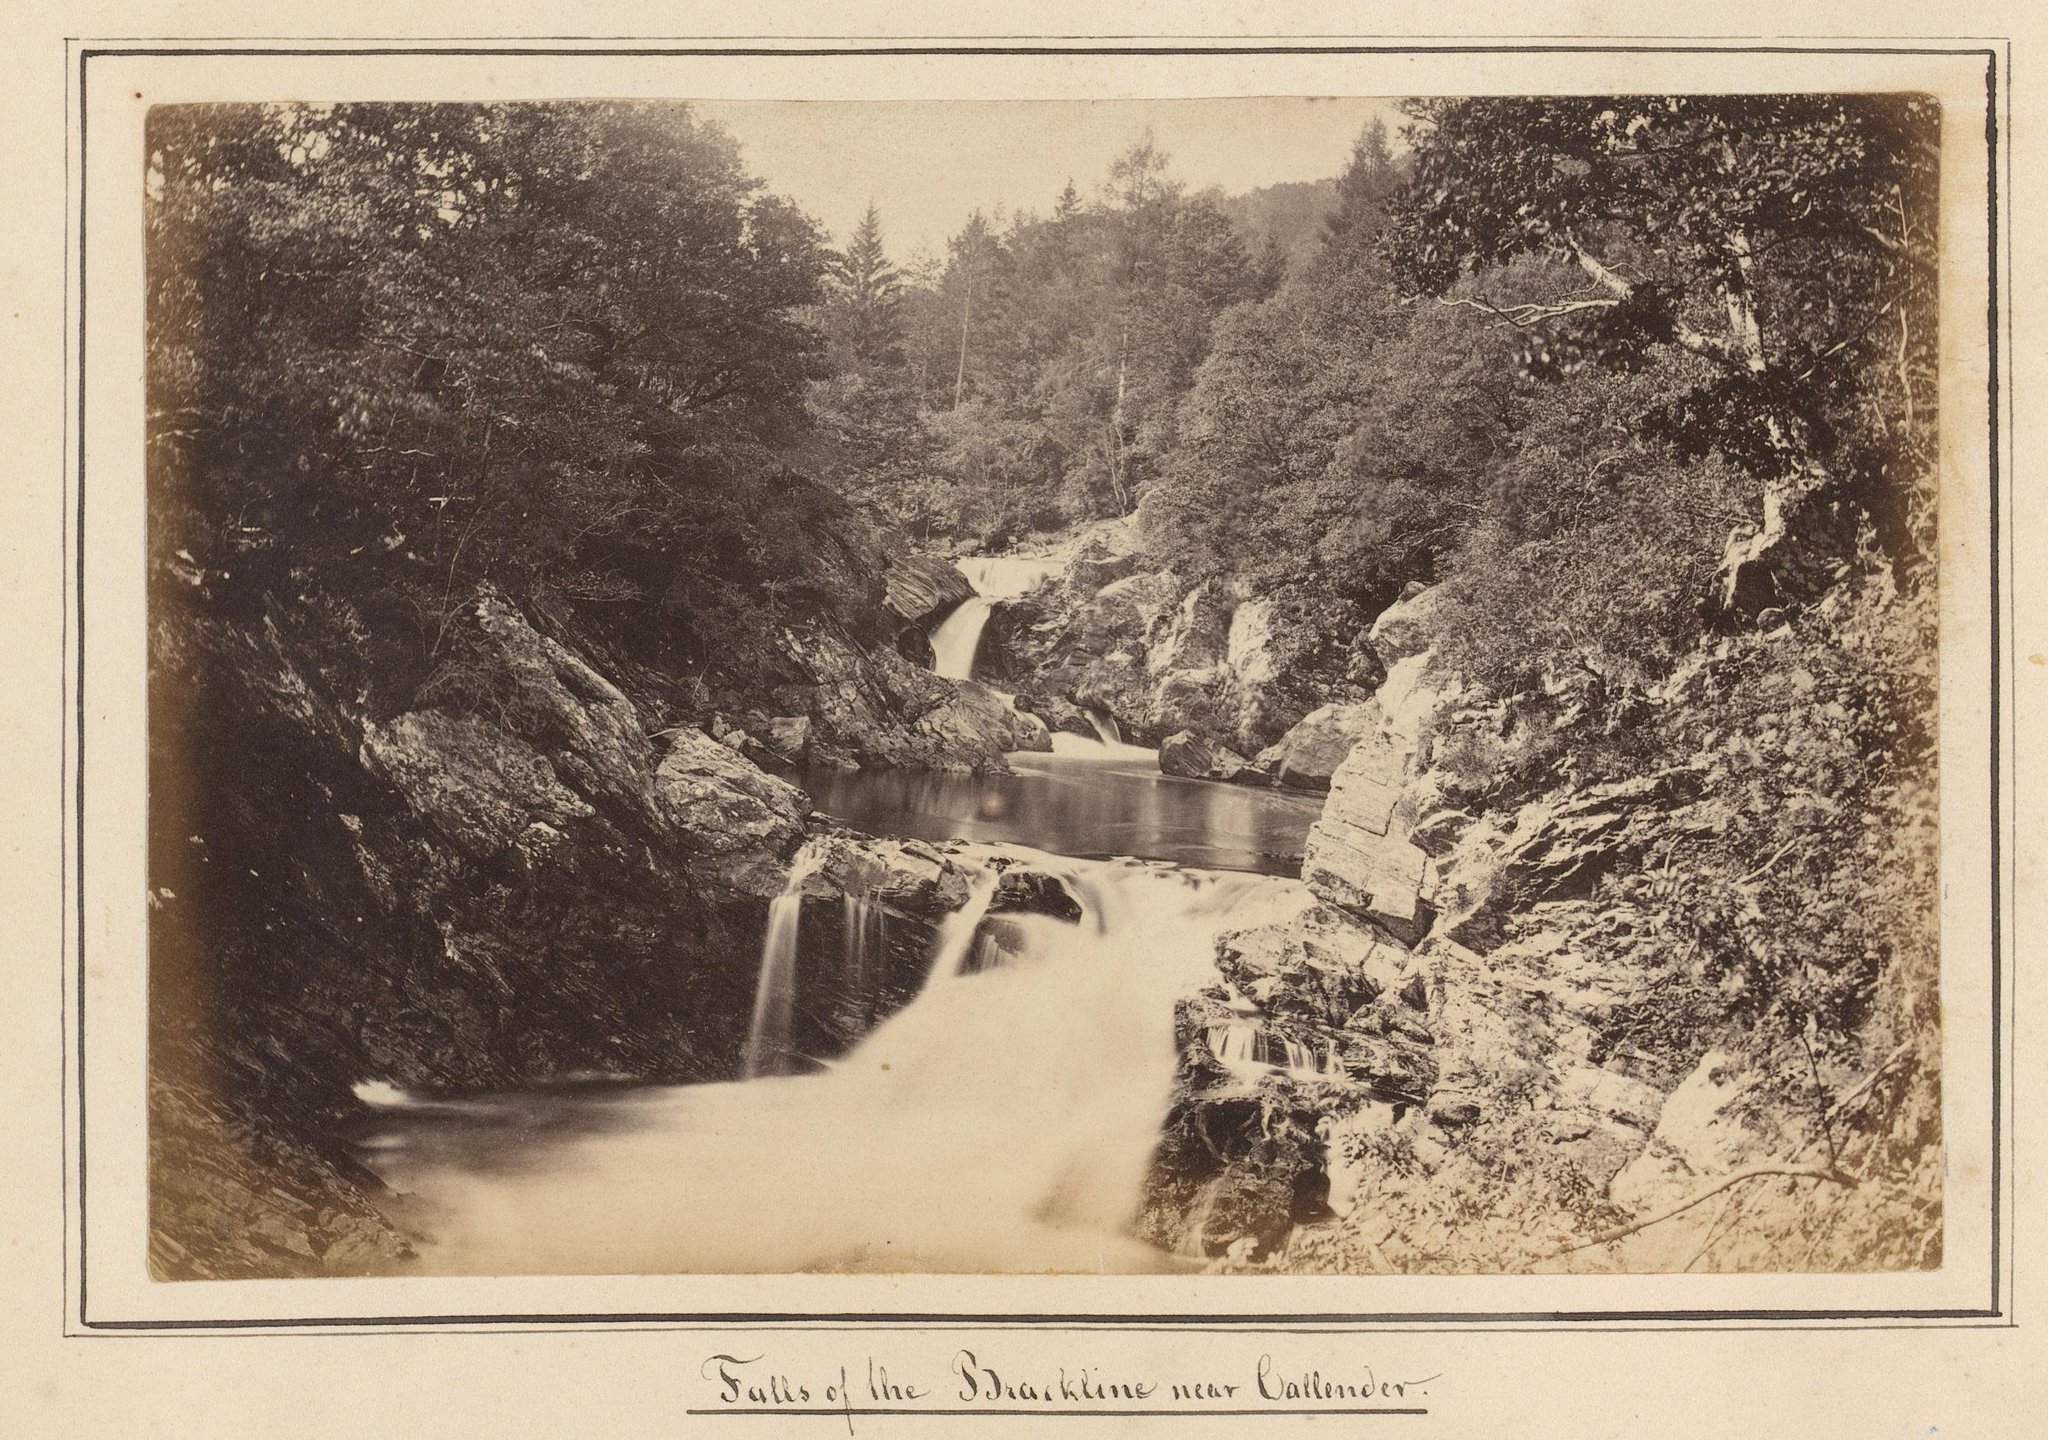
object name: photograph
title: Falls of the Brackline near Callender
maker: Anonymous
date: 1870-1890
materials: paper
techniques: albumen print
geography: bracklinn falls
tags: waterfall